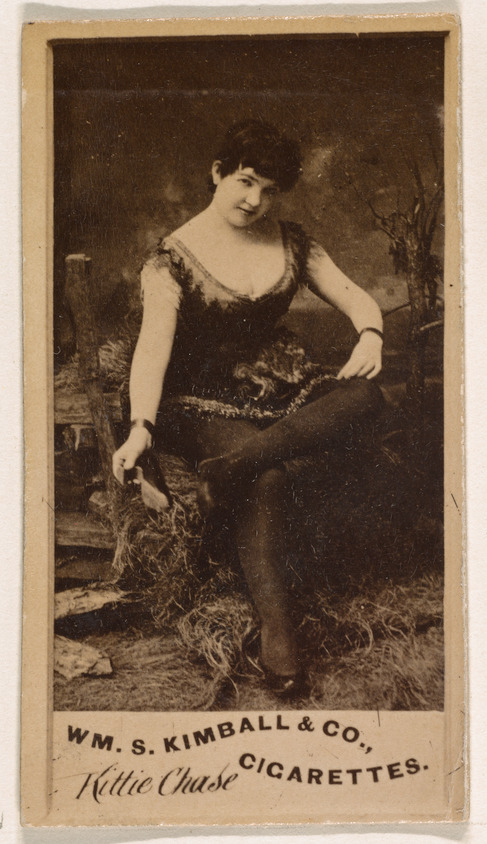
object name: photograph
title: Kittie Chase, from the Actresses series (N203) issued by Wm. S. Kimball & Co.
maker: william s. kimball & company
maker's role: publisher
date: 1889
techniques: color lithograph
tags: portraits,women,actresses